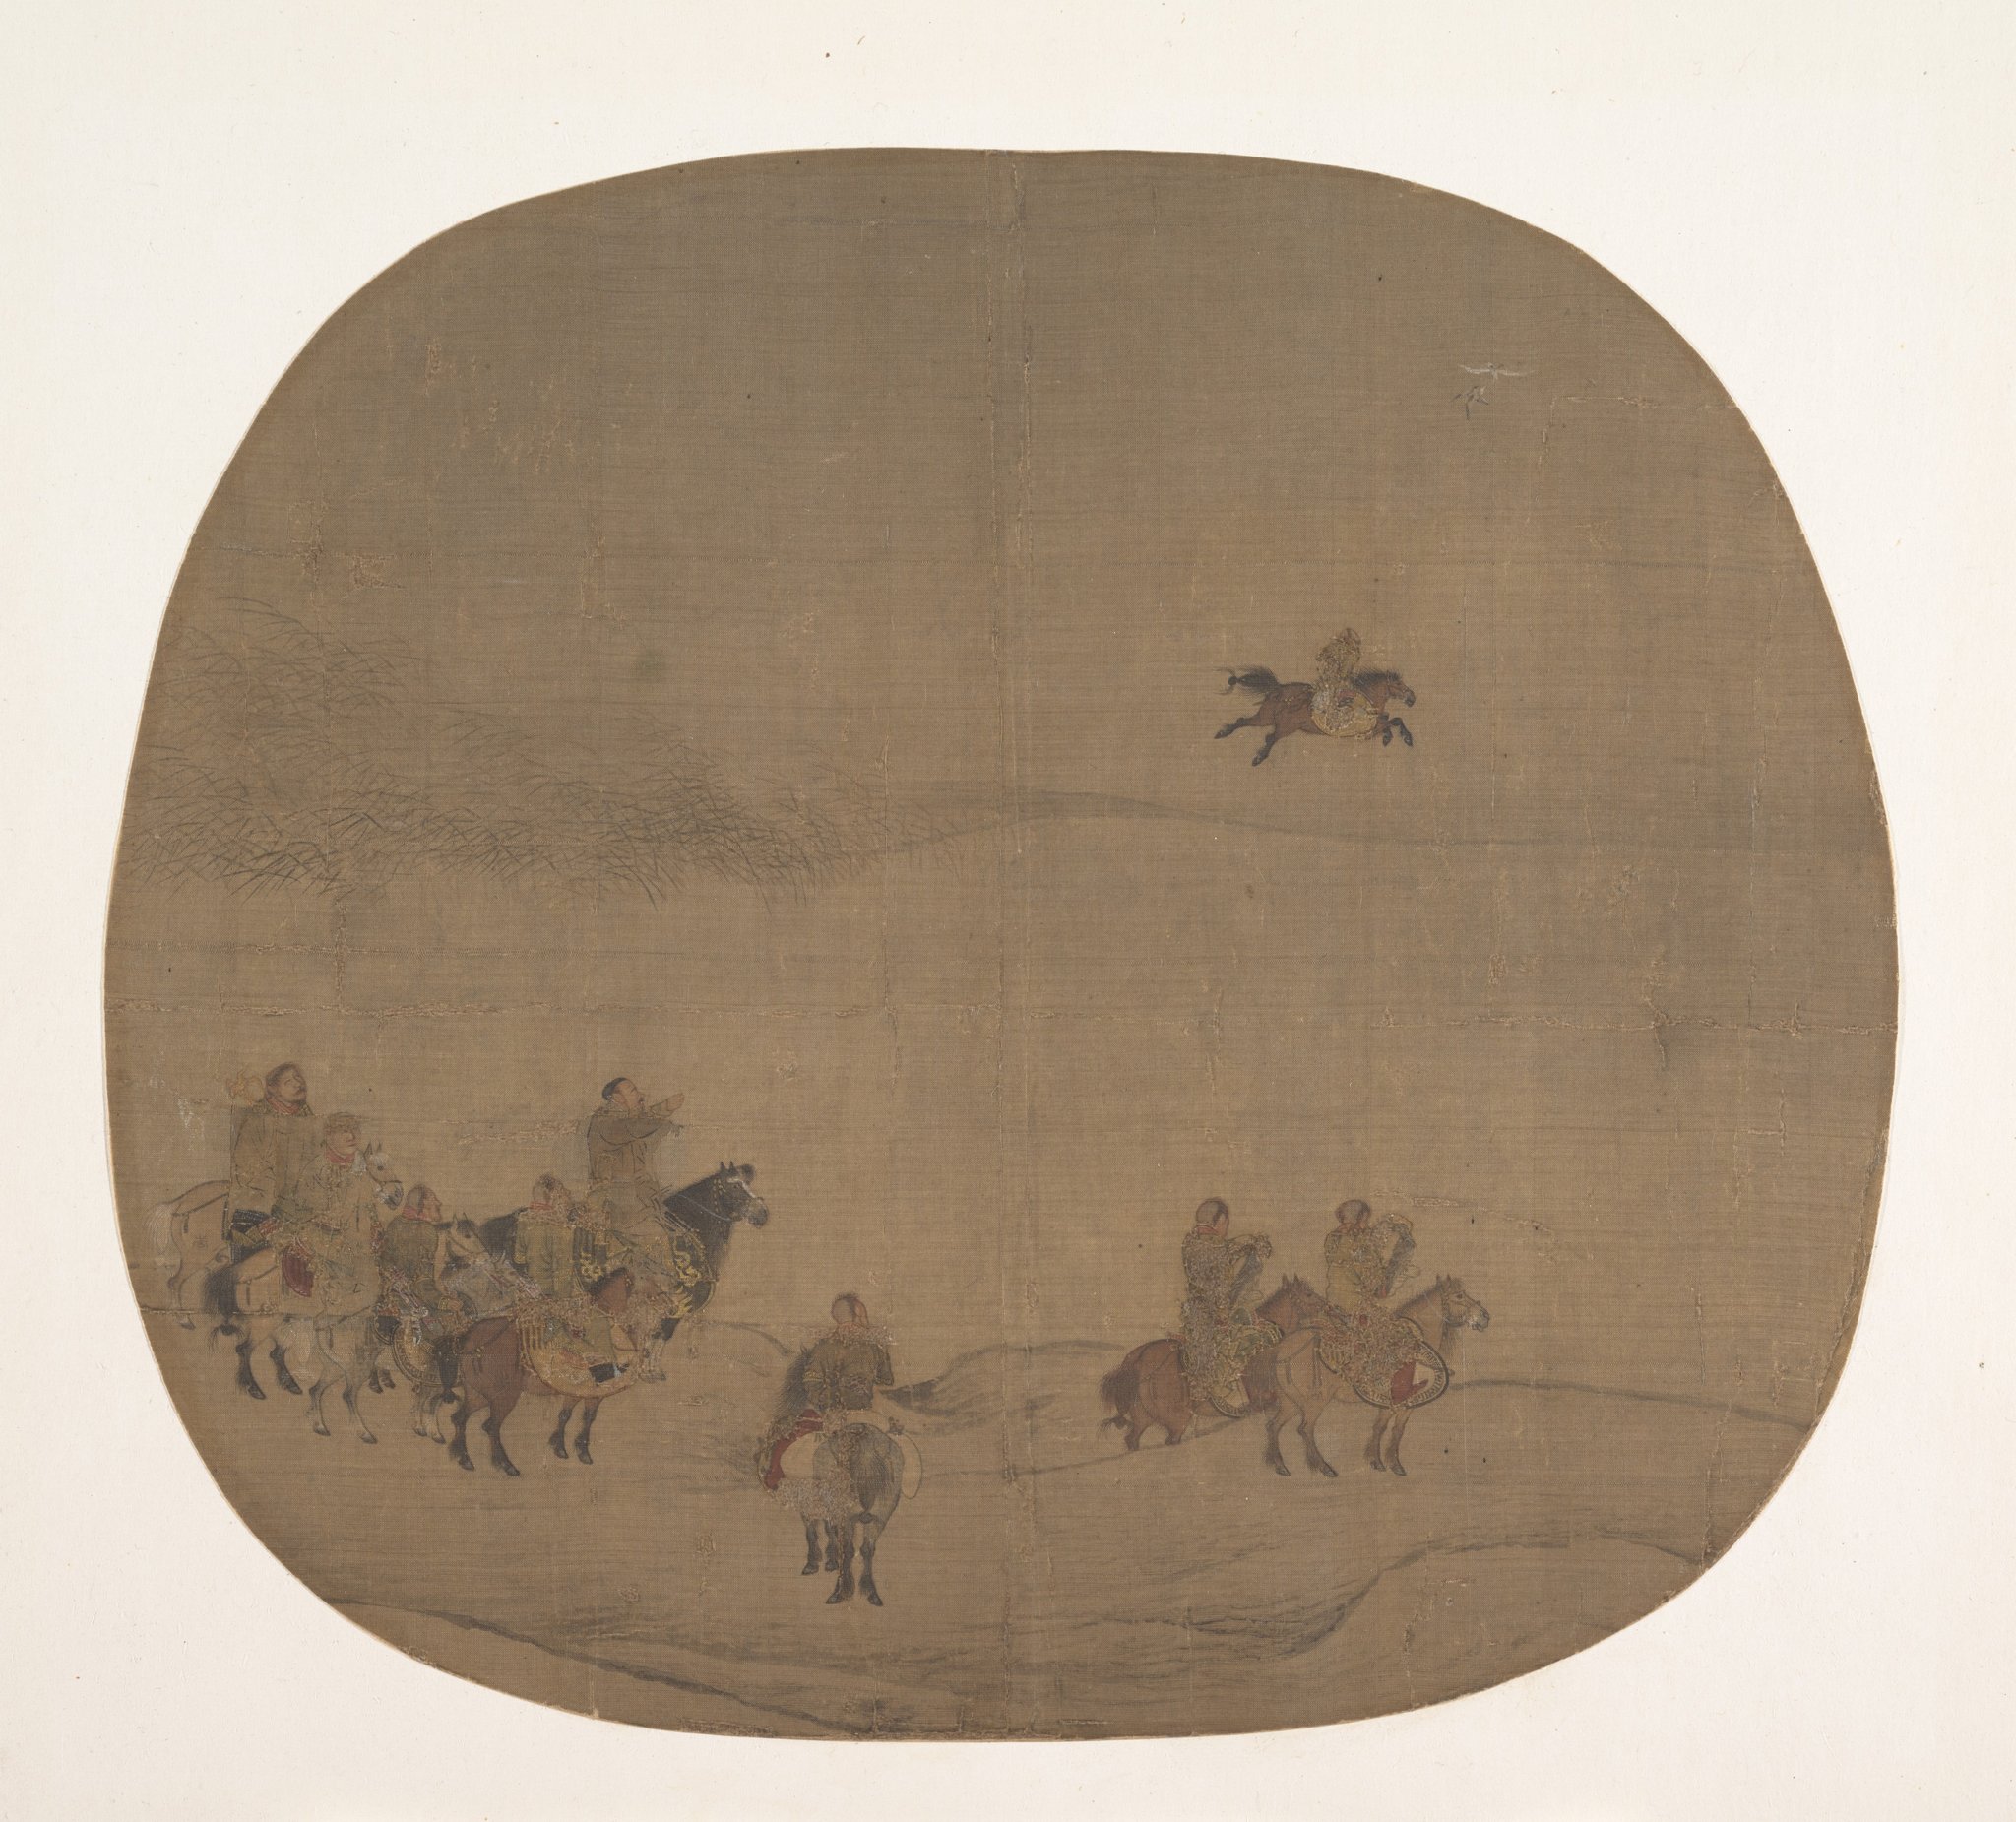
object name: fan mounted a an album leaf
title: Nomads hunting with falcons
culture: chinese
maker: chen juzhong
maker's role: artist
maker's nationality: chinese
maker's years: 1200-1230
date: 1201-1233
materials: ink, silk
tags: falcons,men,hunting,horses